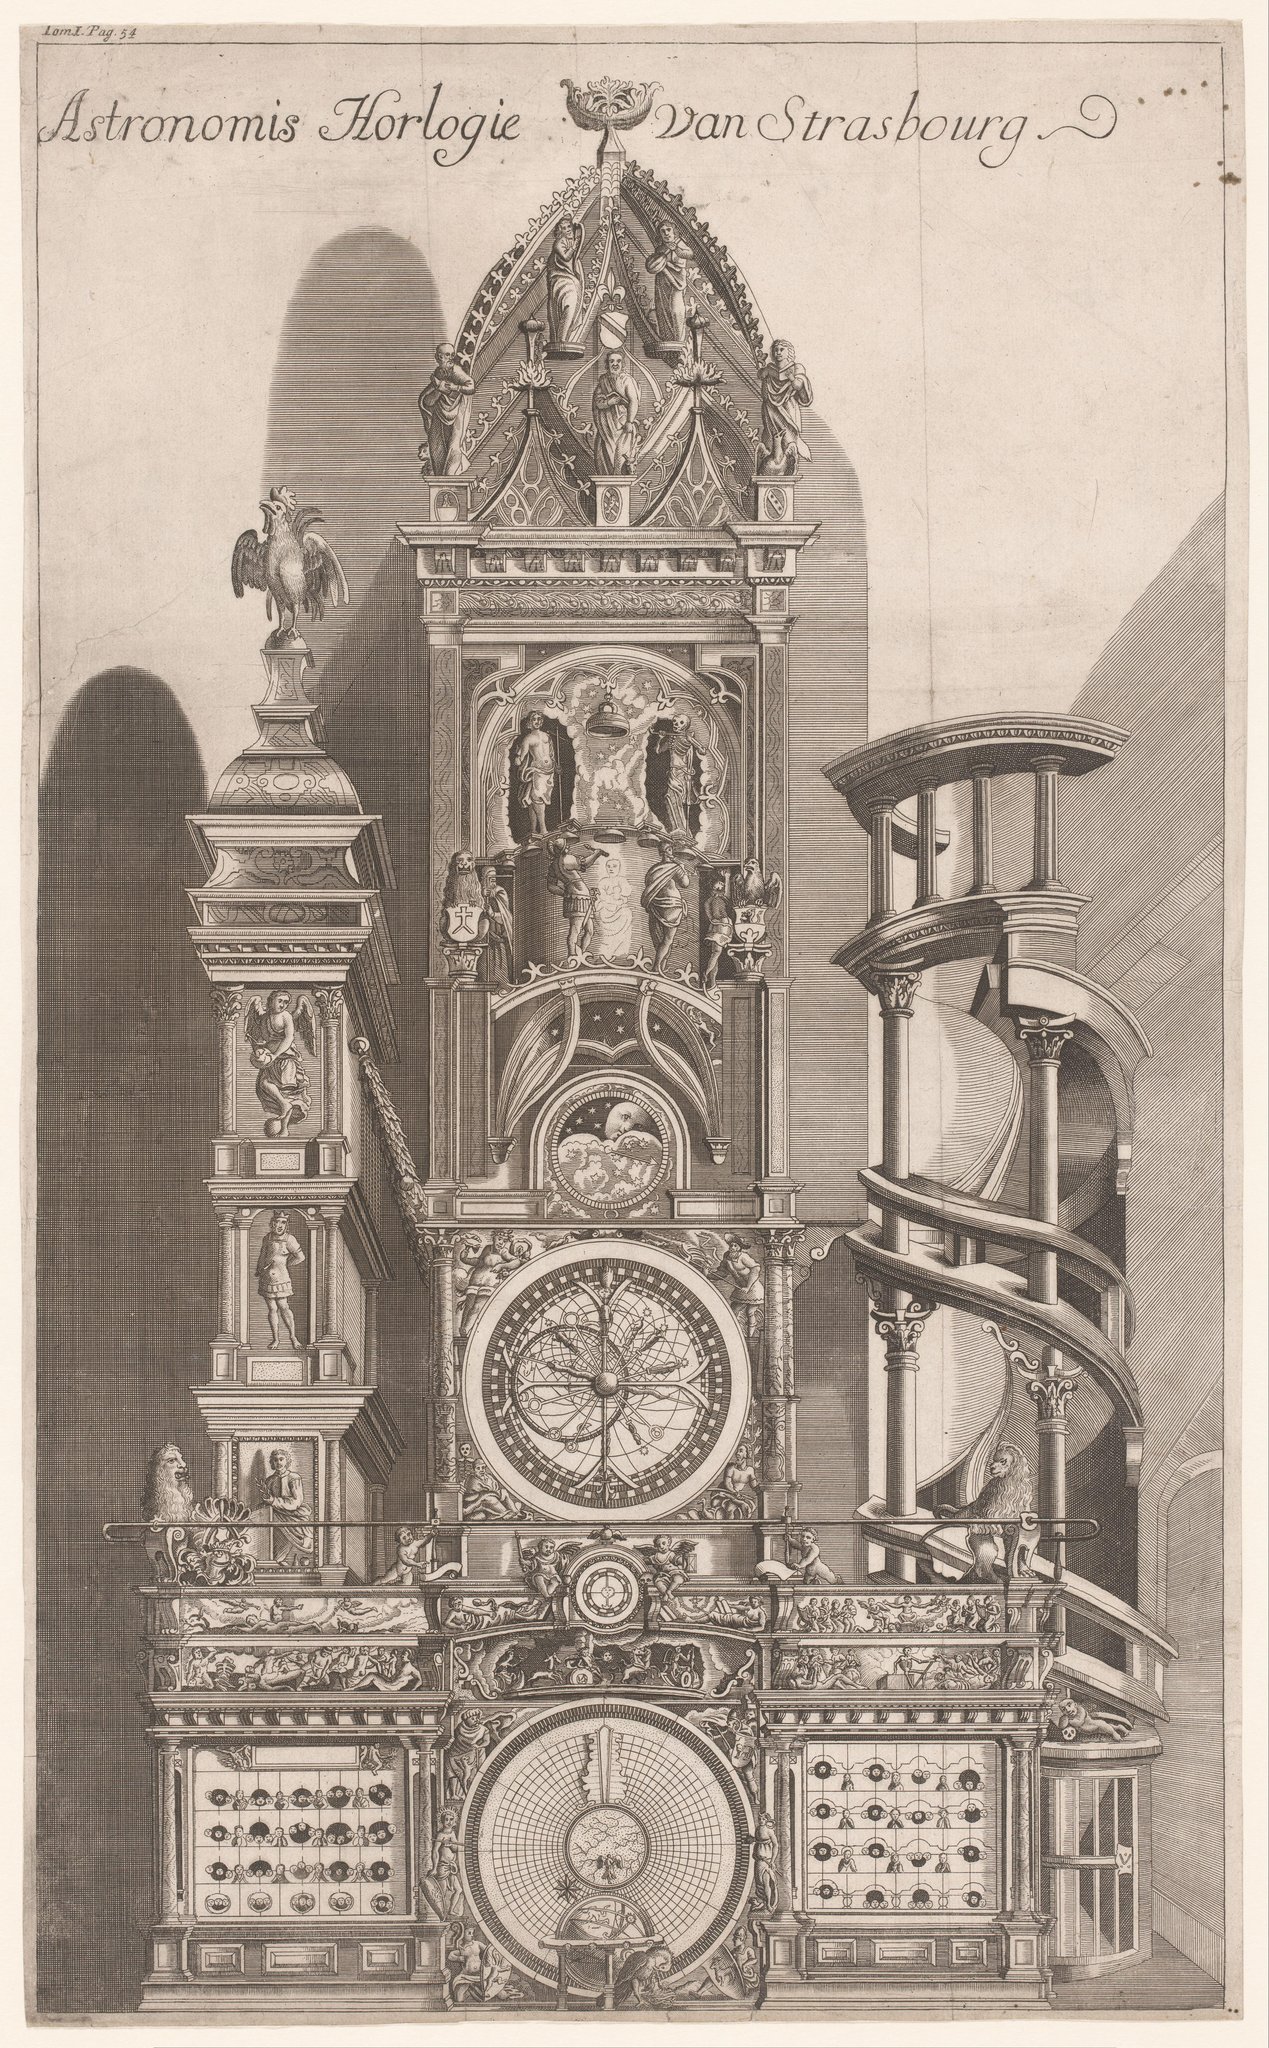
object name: book illustration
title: Astronomisch uurwerk in de kathedraal van Straatsburg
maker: Anonymous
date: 1650-1750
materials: paper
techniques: engraving, etching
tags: astronomical instruments, clock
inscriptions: collector's mark: Lugt 2228